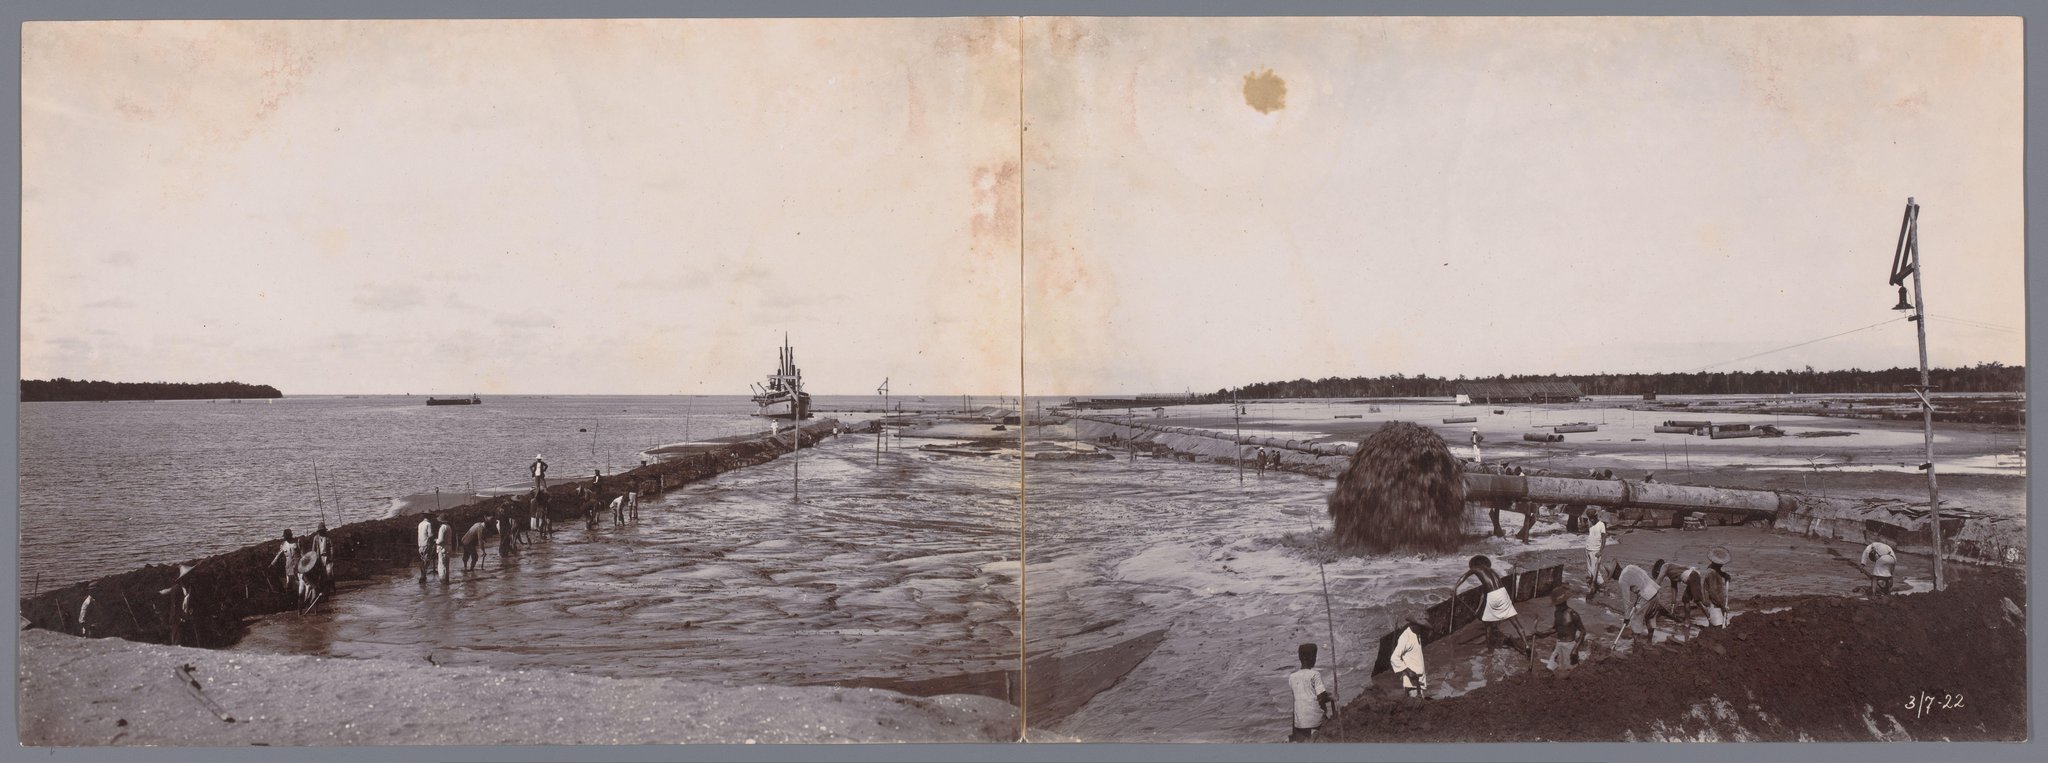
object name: photograph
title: Oceaanhaven Belawan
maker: Anonymous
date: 1922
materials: photographic support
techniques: gelatin silver print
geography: belawan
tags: harbour, building-site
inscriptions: date: ‘3/7-22’, inscription: ‘No 177 Zand spuiten i/d grondverbetering’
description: Opspuiten van zand. Genummerd: 177. Twee foto's aan elkaar geplakt. Onderdeel van de groep van losse foto's over de aanleg van de haven Belawan aan de kust voor Medan, Sumatra 1921-1922.